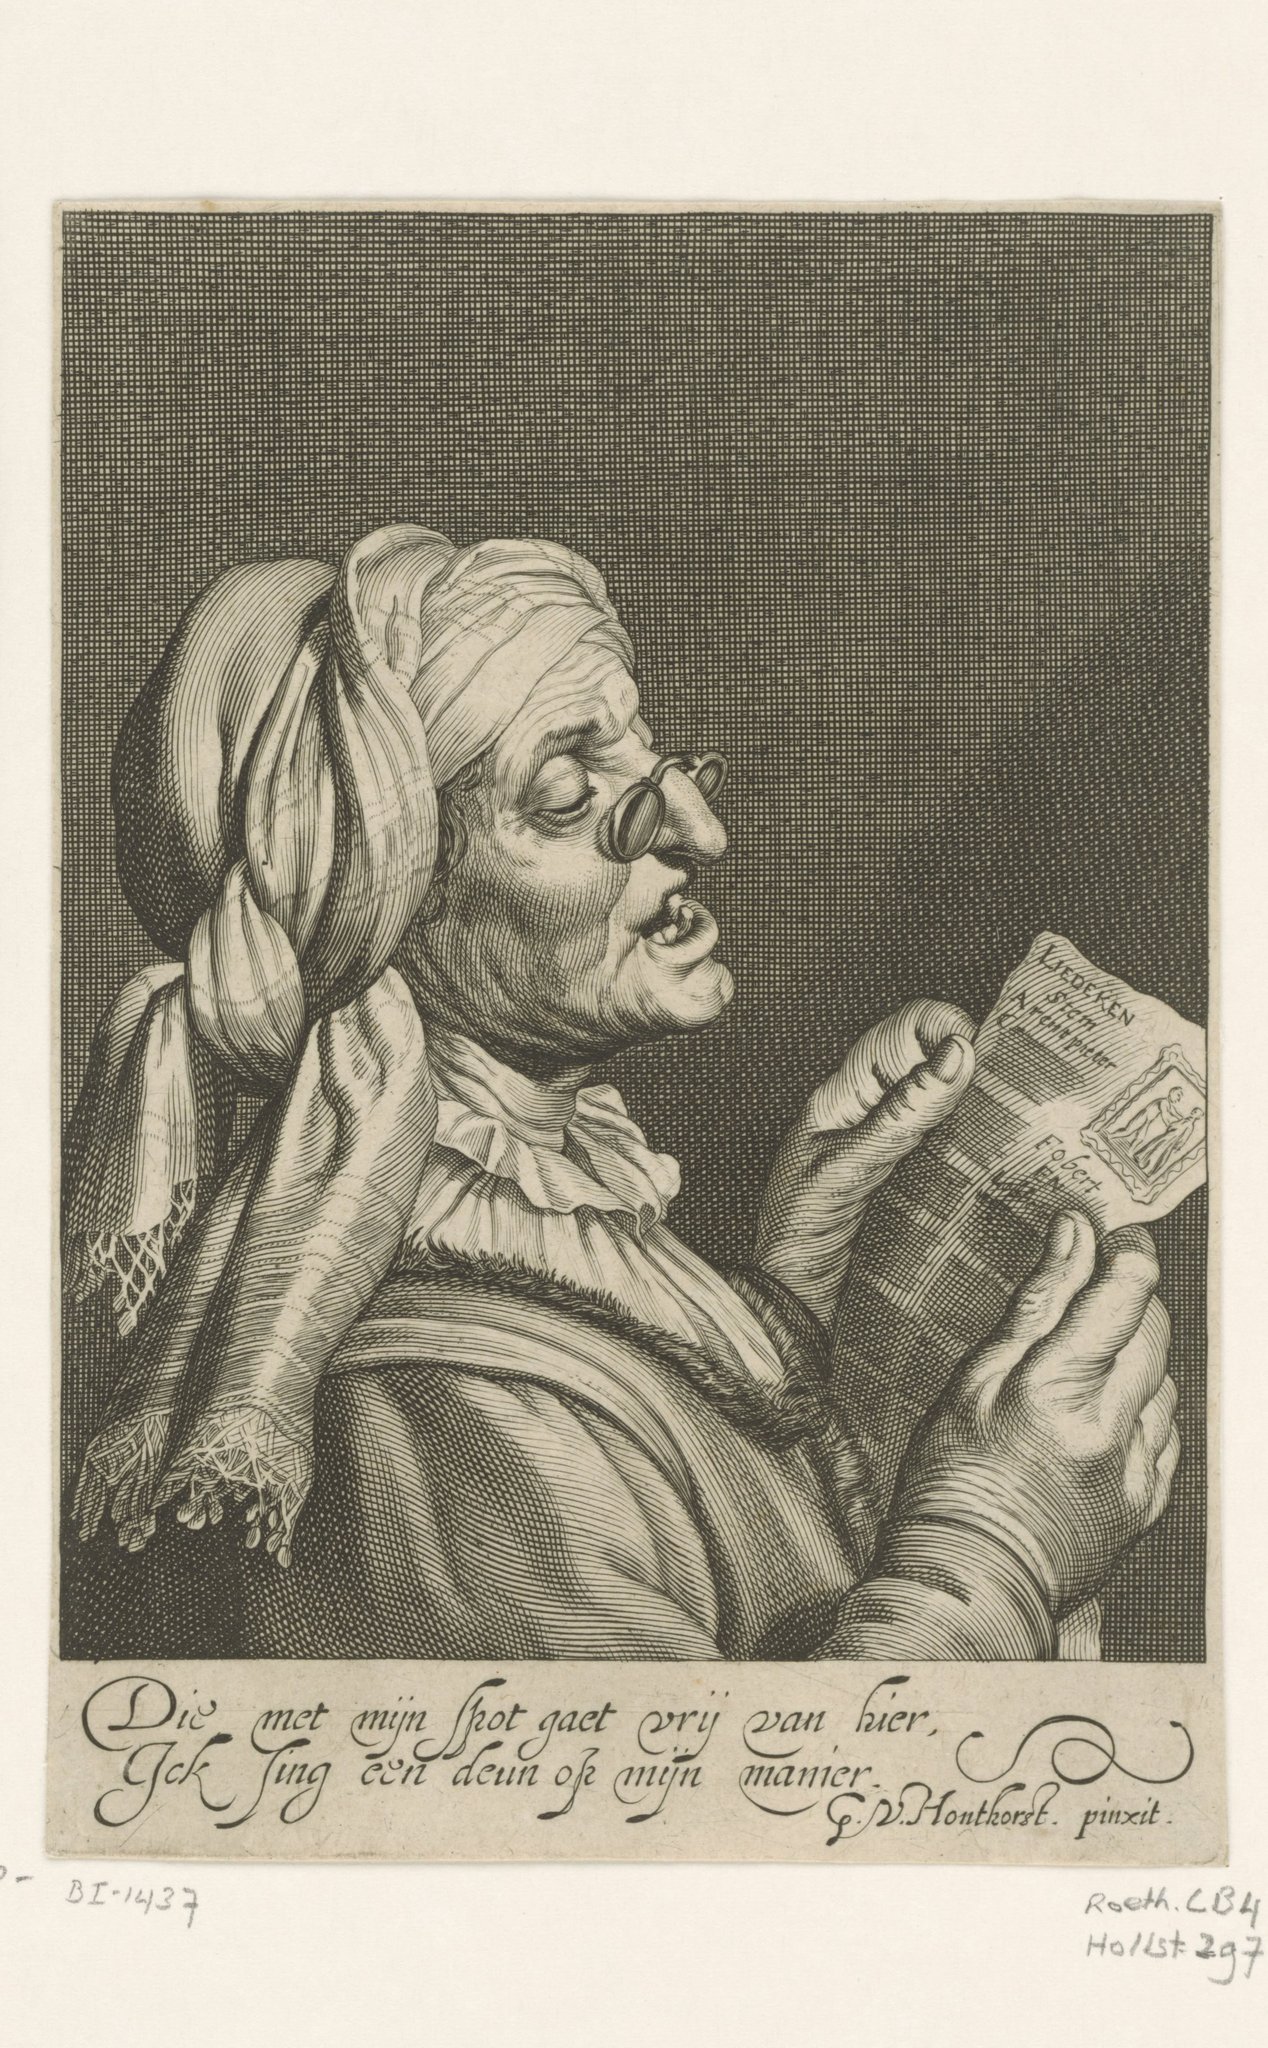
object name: print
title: Zingende vrouw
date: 1620-1665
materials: paper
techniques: engraving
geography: utrecht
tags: singer without accompaniment, printed edition of musical score, art (+ singing)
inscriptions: collector's mark: Lugt 240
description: Een oude vrouw met bril op de neus zingt van een muziekblad. Met tweeregelige Nederlands onderschrift.